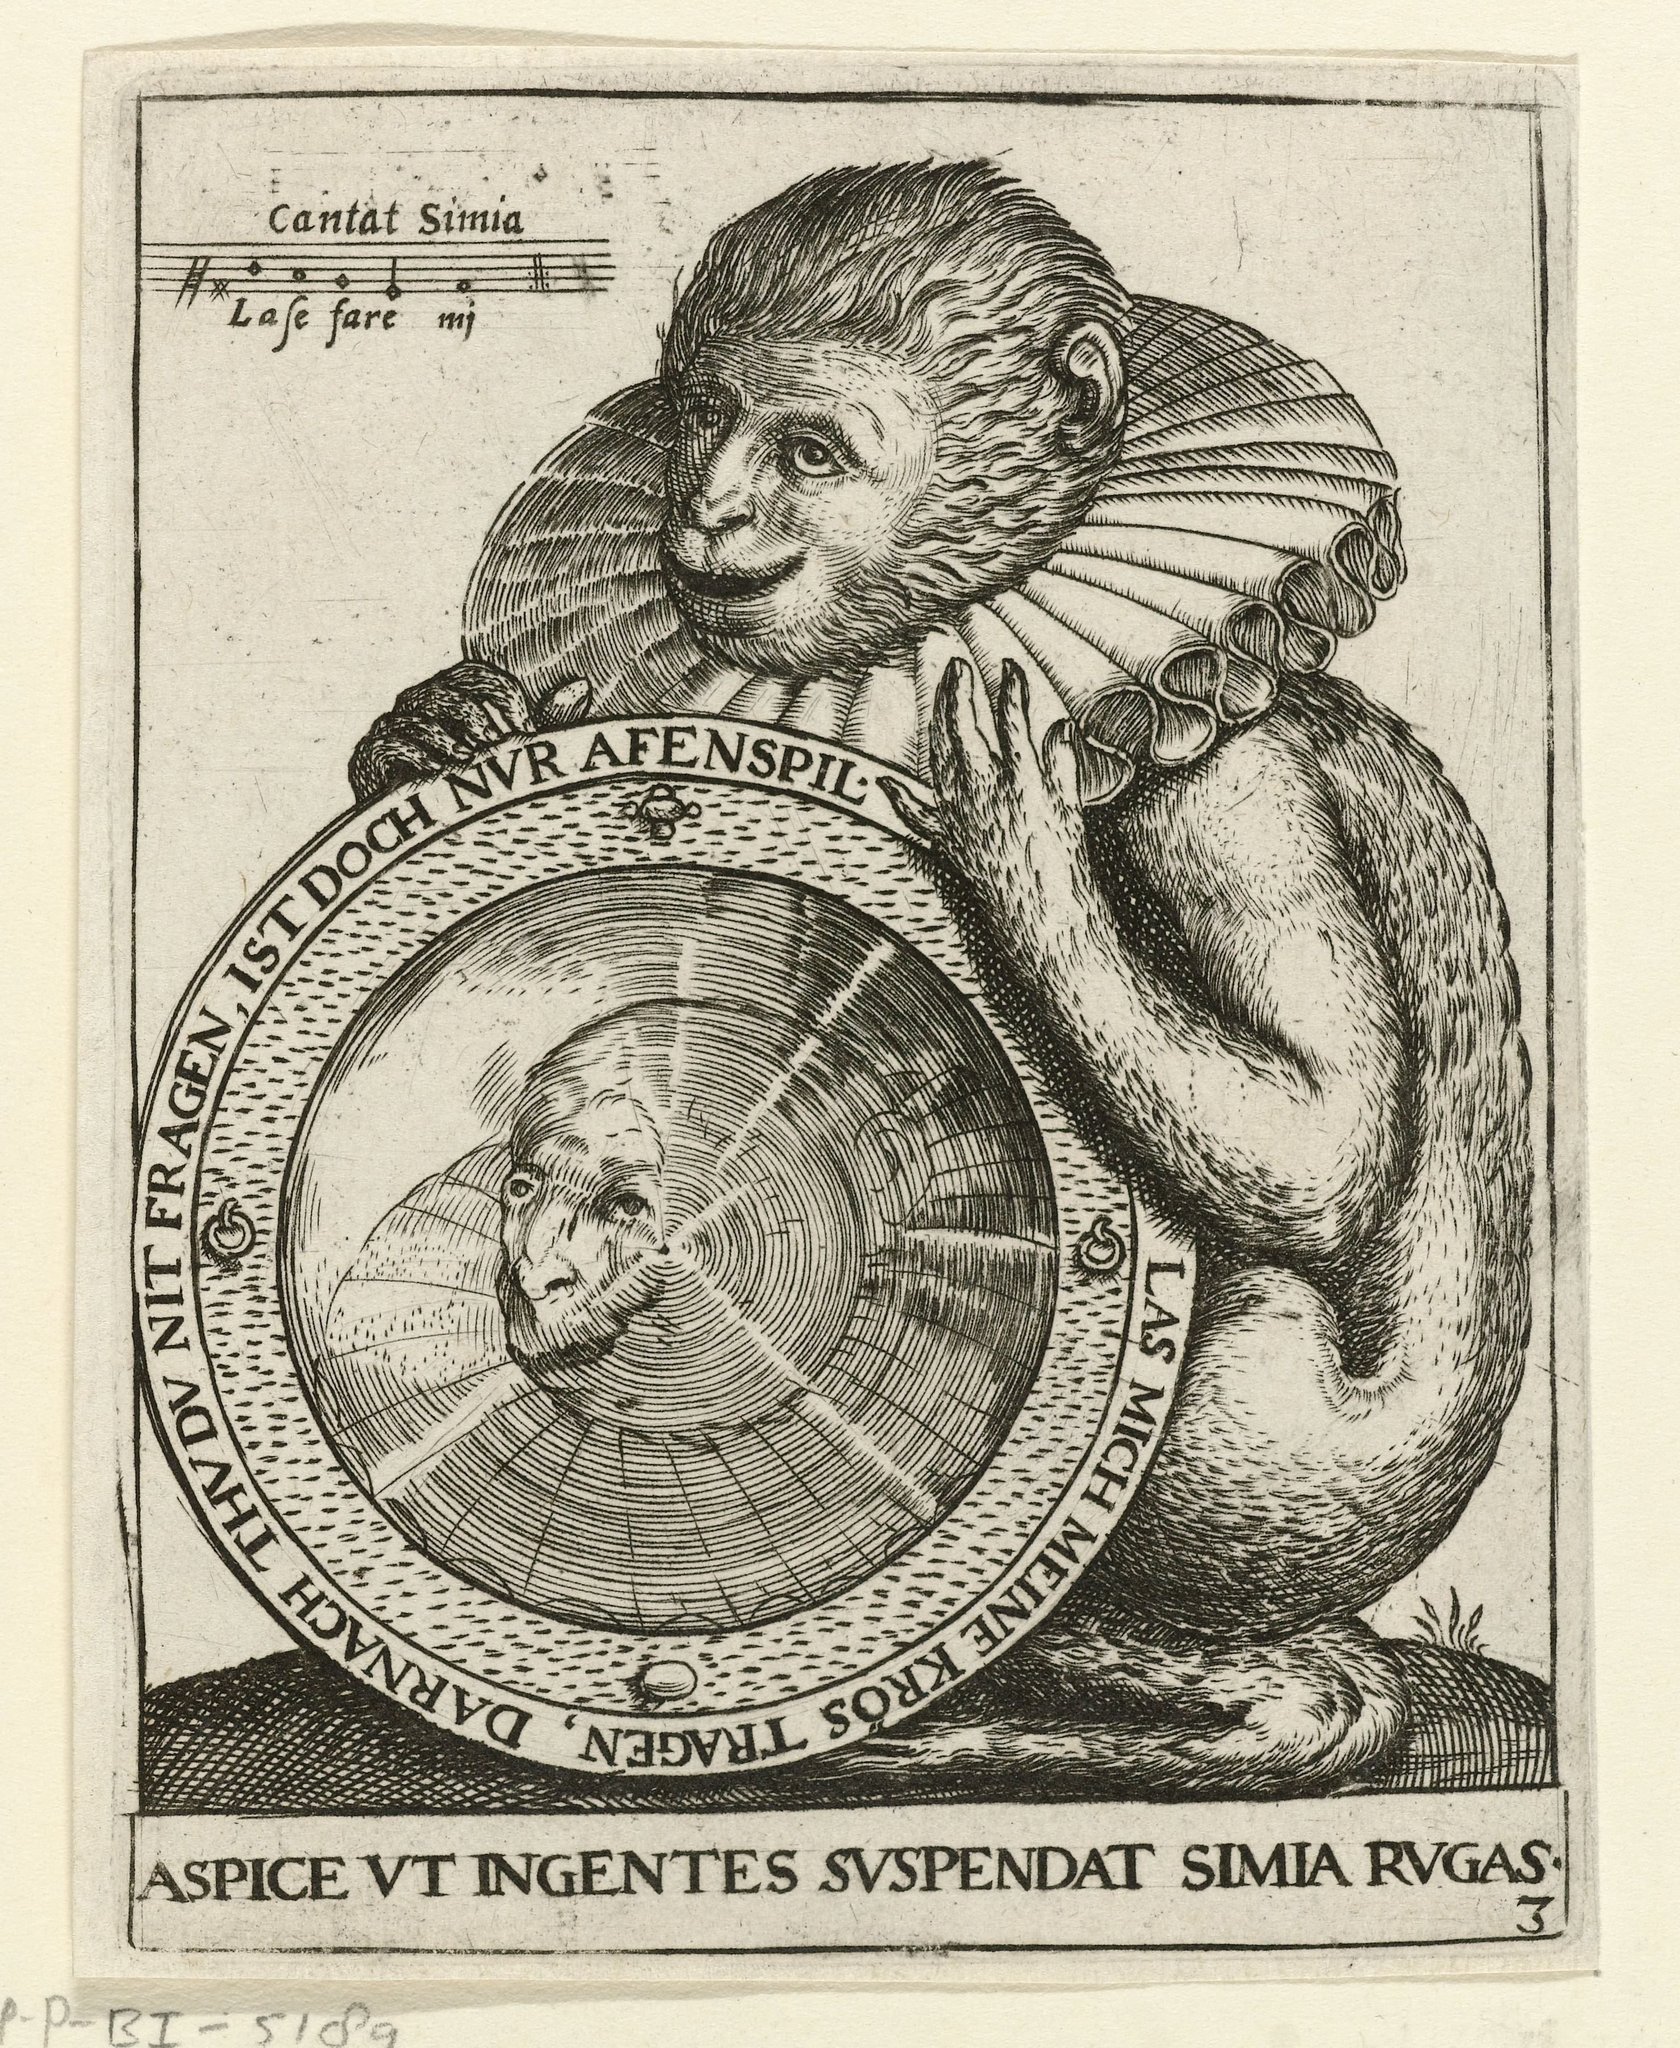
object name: cognizance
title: Emblemata Saecularia, 1596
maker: johann theodor de bry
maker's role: print maker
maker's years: 1561-1623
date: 1596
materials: paper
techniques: engraving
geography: germany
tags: monkeys, apes, neck-gear ~ clothing (with name), (group of) the seven deadly sins (symbolized)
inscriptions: caption: ‘ASPICE UT INGENTES SUSPENDAT SIMIA RUGAS’, number: ‘3’, collector's mark: Lugt 240, : ‘muzieknoten met tekst Cantat Simia (erboven) en la, se, fa,re,mij (eronder)’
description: Allegorie op de ijdelheid van de mens. Een aap, getooid met grote plooikraag, zit bij een ronde spiegel waarin zijn spiegelbeeld is te zien. In de rand van de spiegel is te lezen: LASS MICH MEINE KROS (kraag) TRAGEN, DARNACH THU NIT FRAGEN, IST DOCH NUR AFFENSPIEL. Nr. 3 uit de uitgave van 1596, nr. 19 uit de uitgebreide uitgave van 1611.